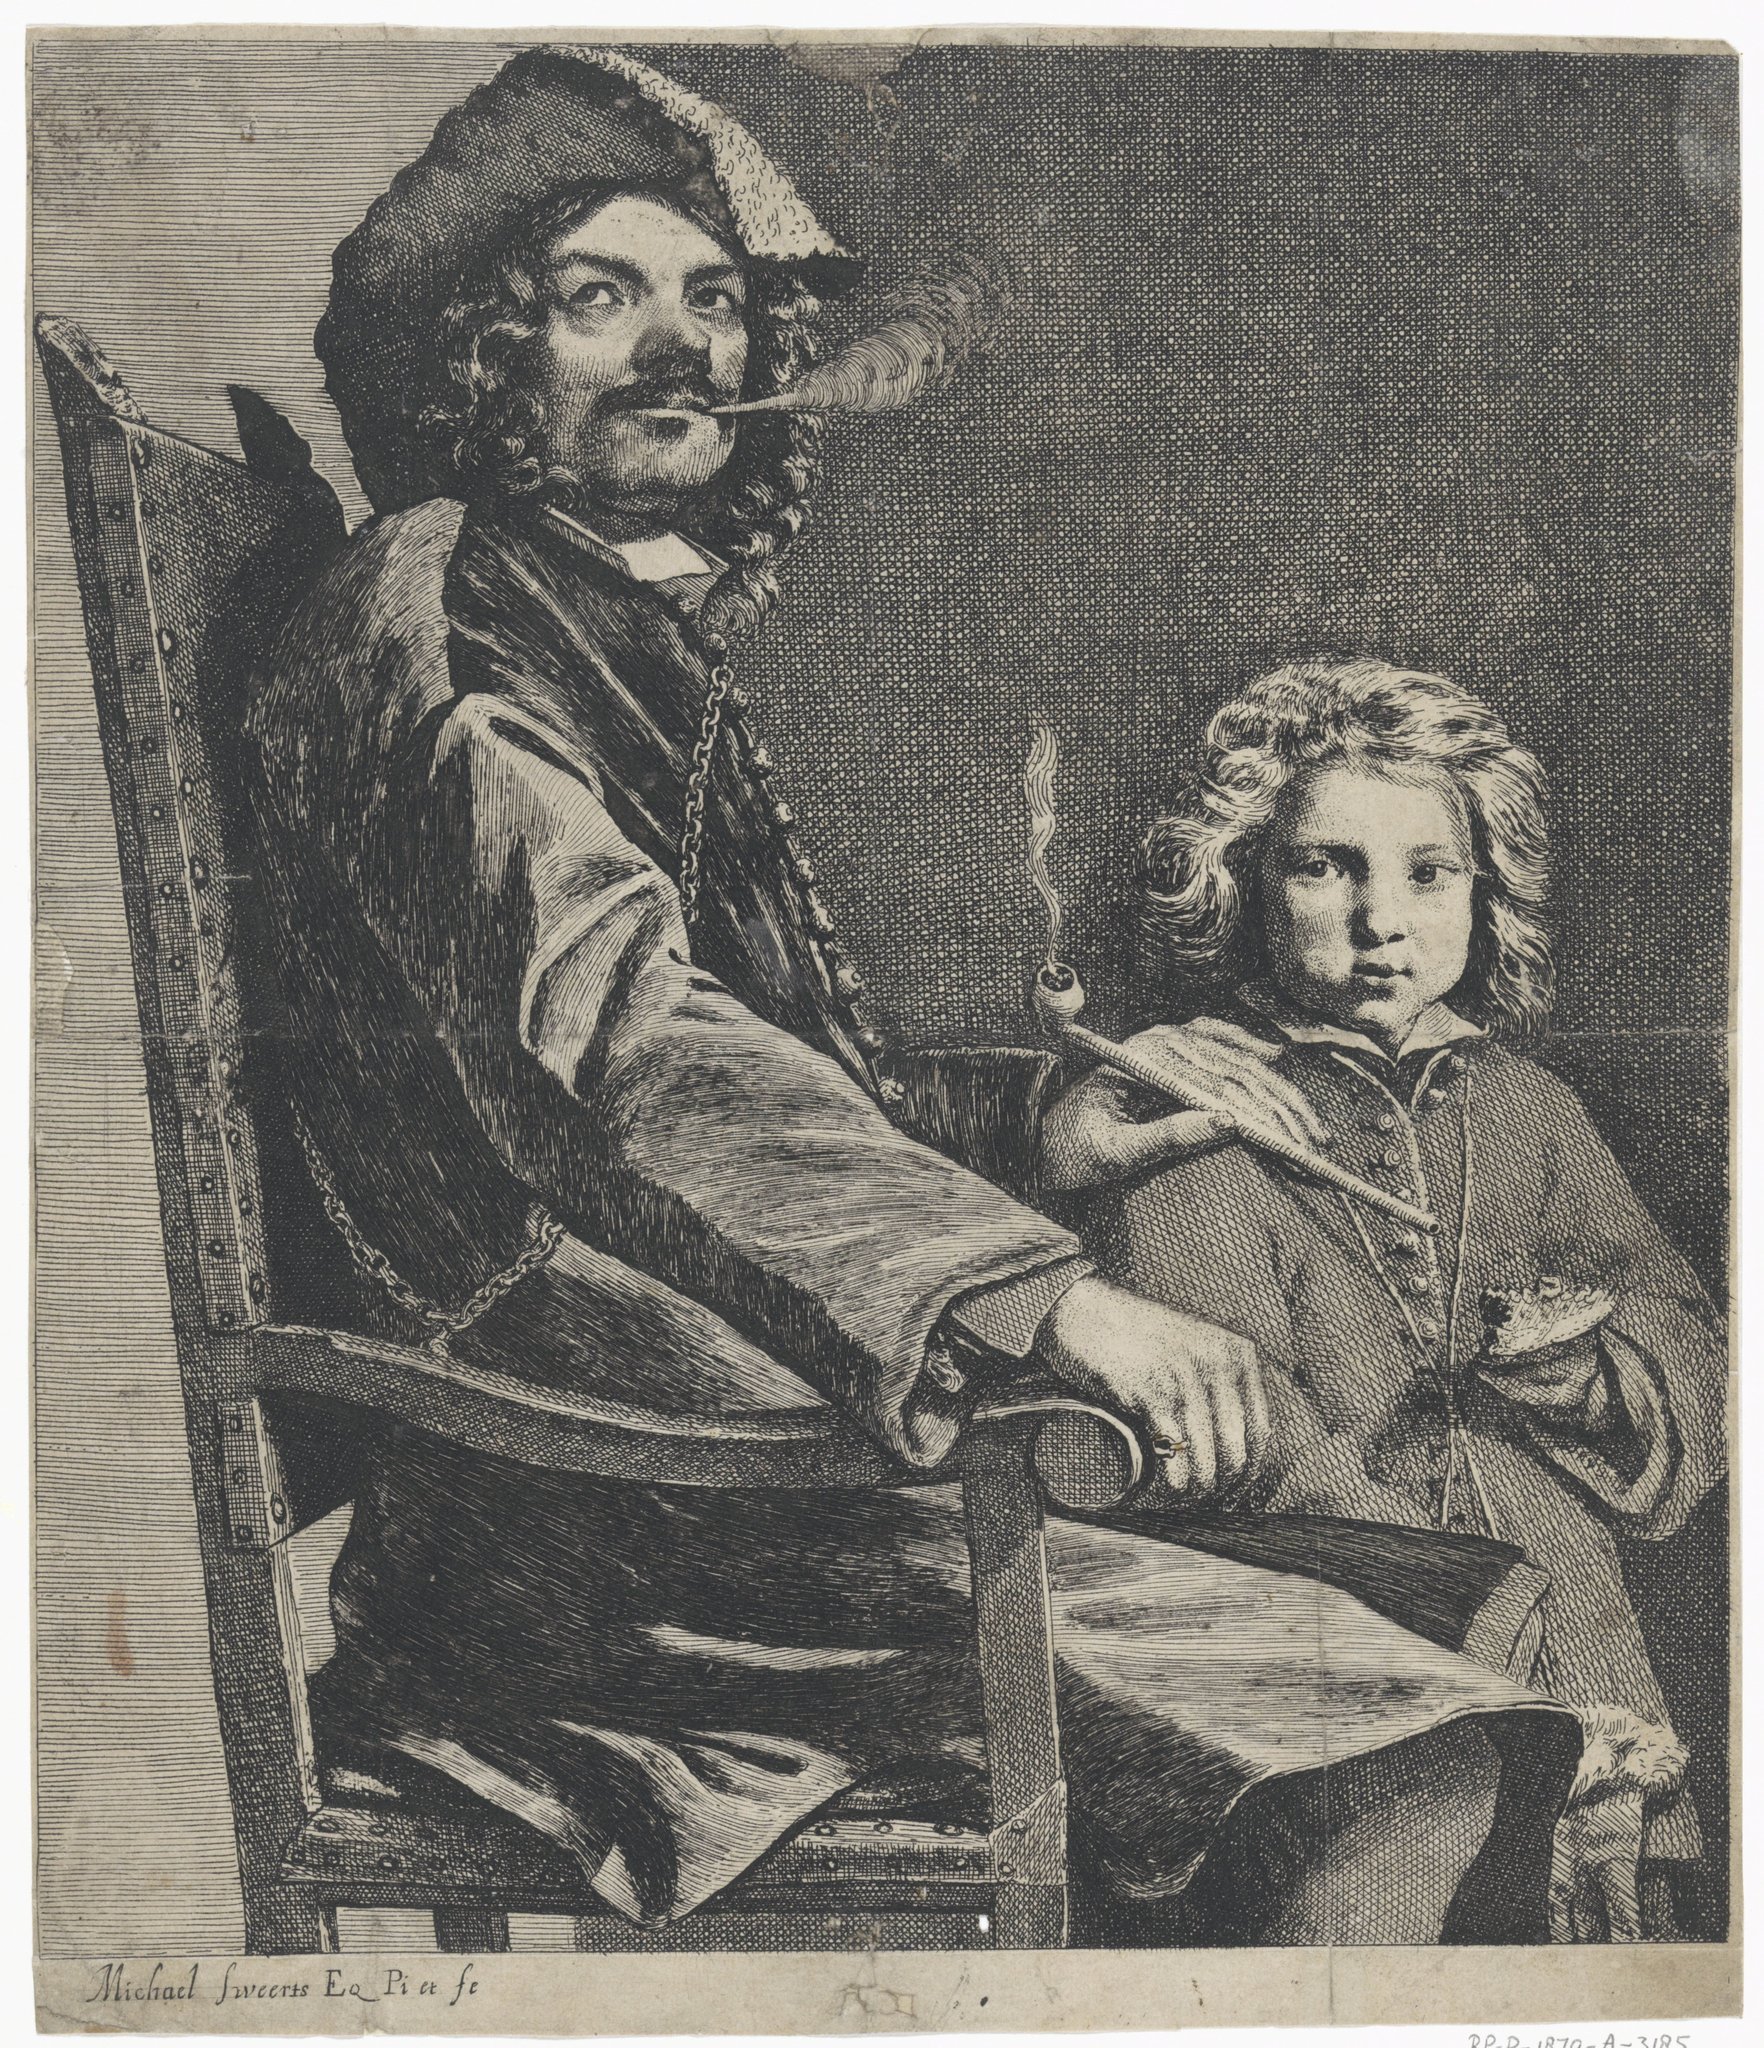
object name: print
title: Pijprokende man in stoel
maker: michael sweerts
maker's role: painter, print maker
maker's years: 1618-1664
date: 1643-1661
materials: paper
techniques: engraving, etching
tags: brussels, painter, print maker, michael sweerts, portrait, self-portrait of painter, pipe ~ tobacco (+ taking (particular) foodstuffs: eating, drinking, smoking, chewing, etc.)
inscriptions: collector's mark: Lugt 2610, collector's mark: Lugt 2228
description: Een pijprokende man, mogelijk Michiel Sweerts, zit in een armstoel. Hij houdt een Goudse pijp in de hand en blaast een rookwolkje uit. Naast hem staat een jongen, die ergens op kauwt.